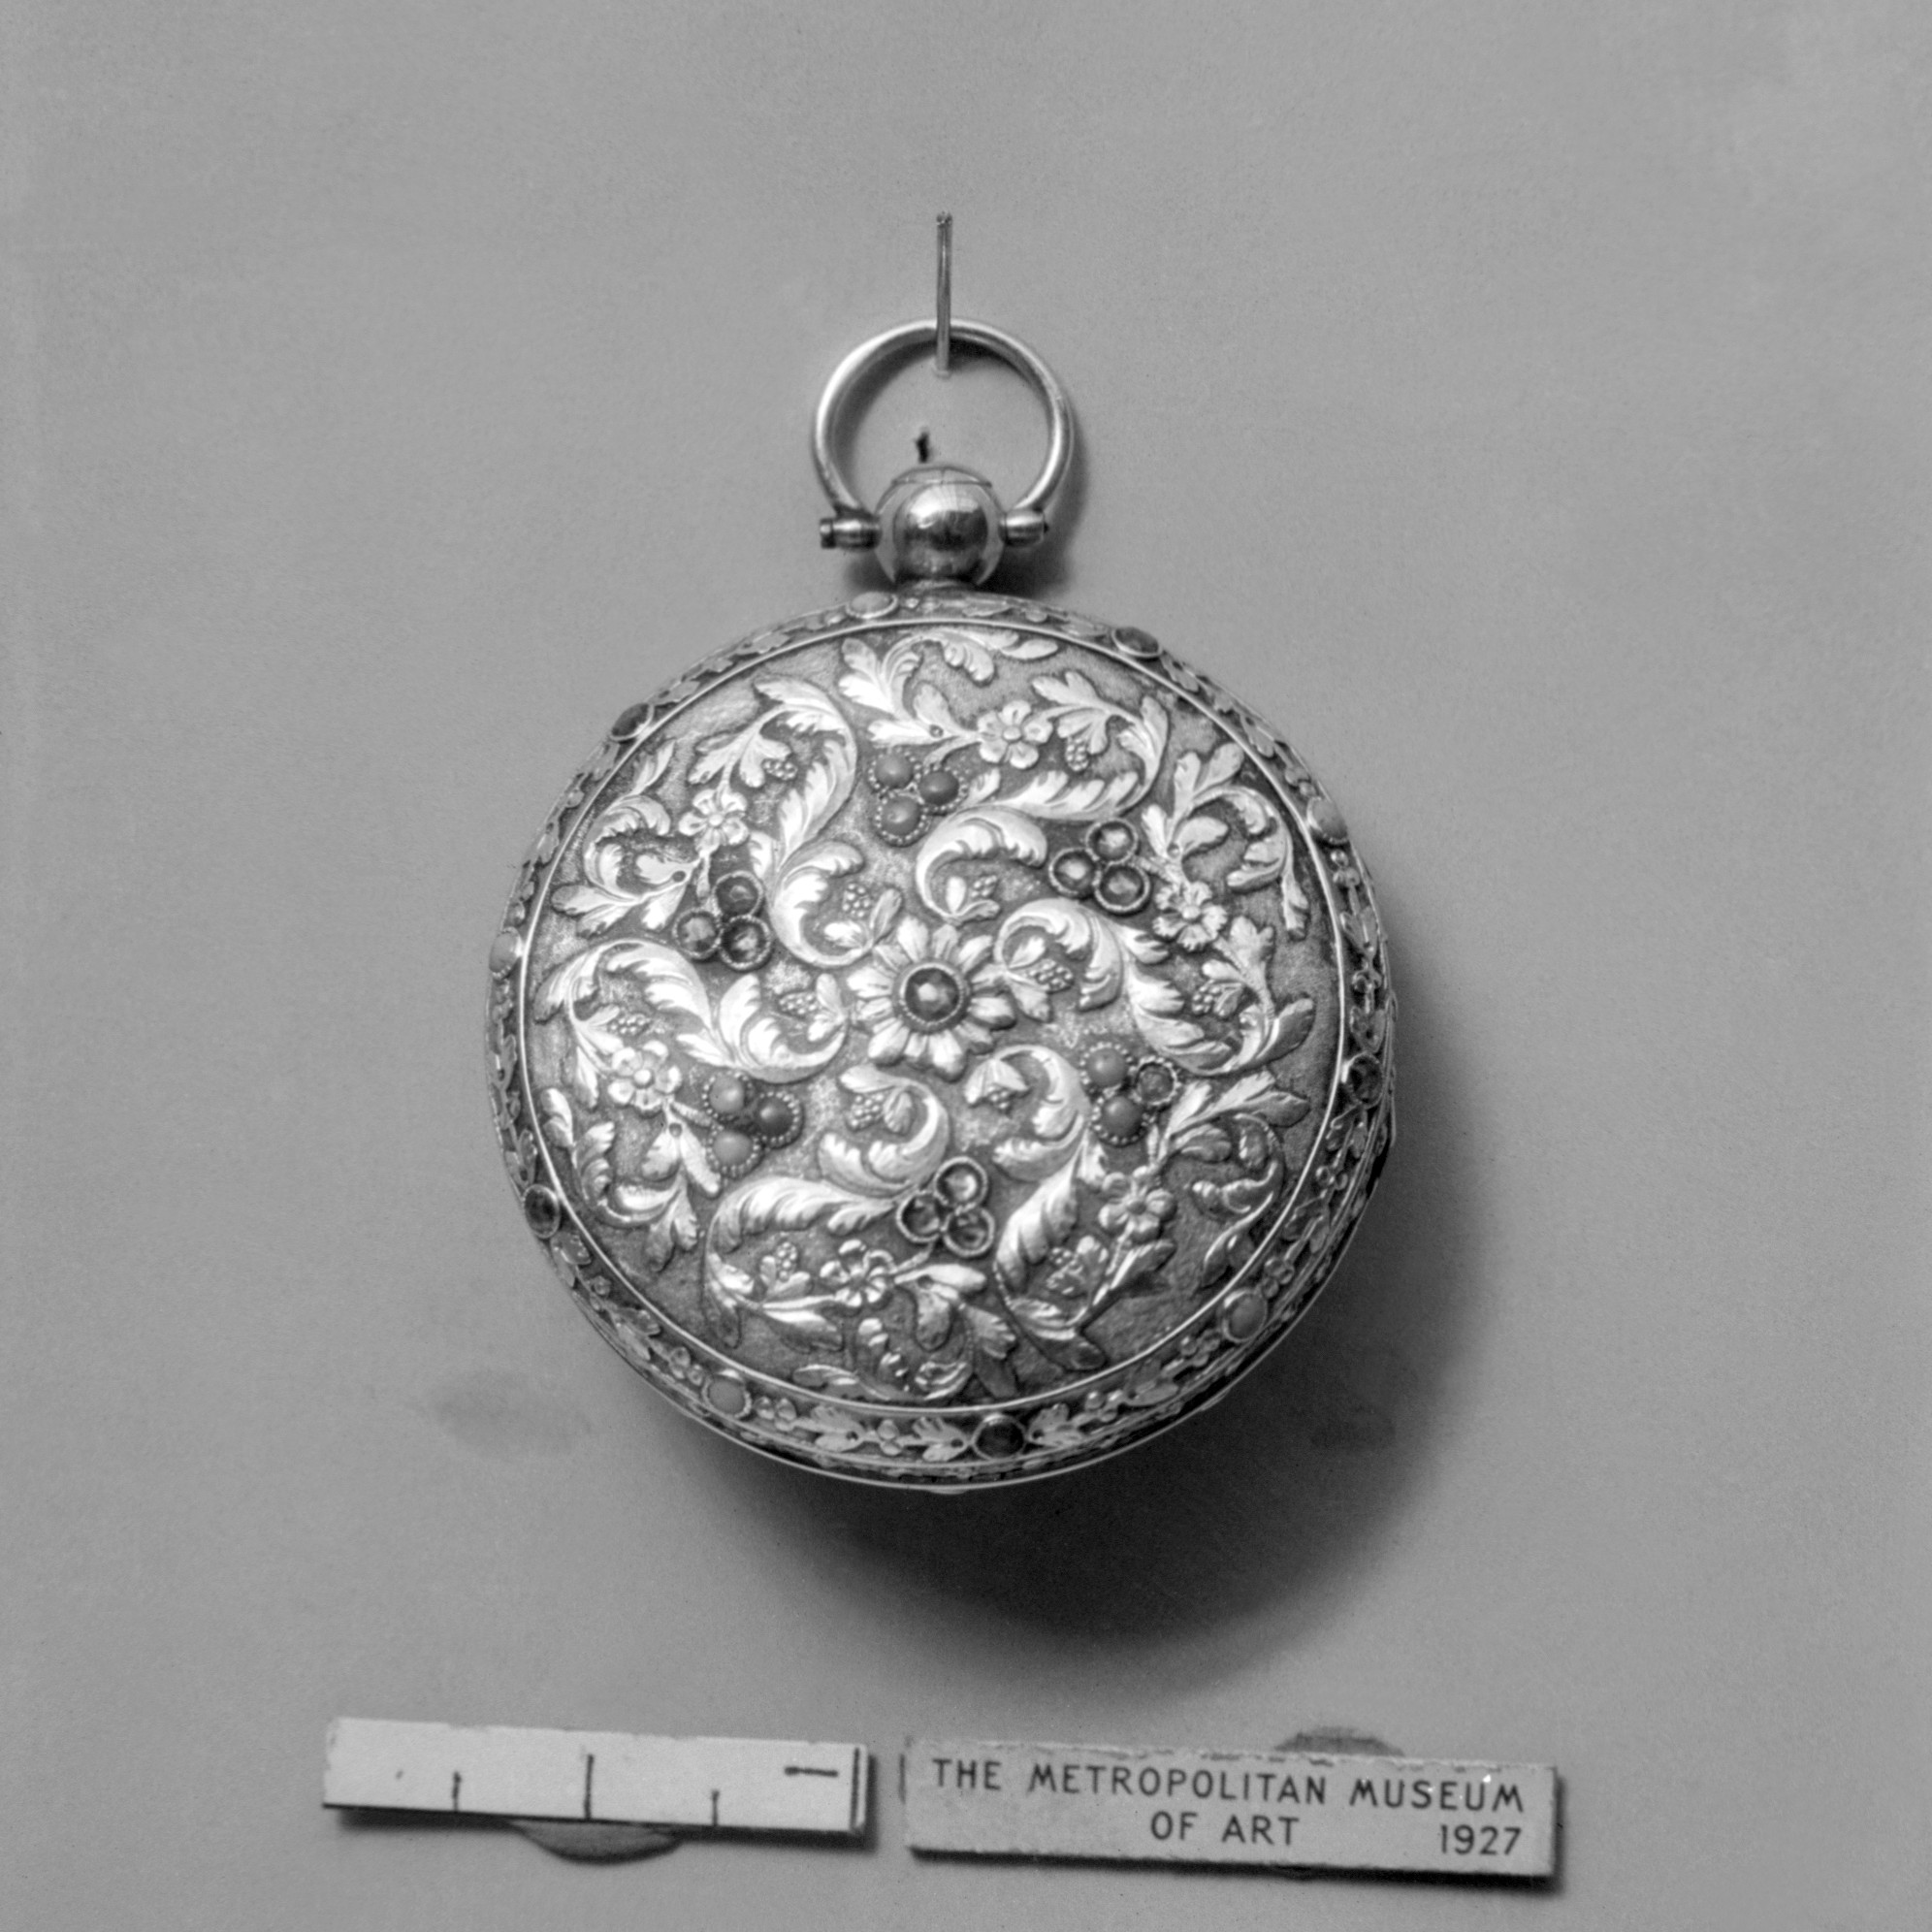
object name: watch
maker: firm of bordier frères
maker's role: maker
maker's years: 1820-1830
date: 1815-1830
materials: garnet, gold, silver, steel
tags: flowers,leaves